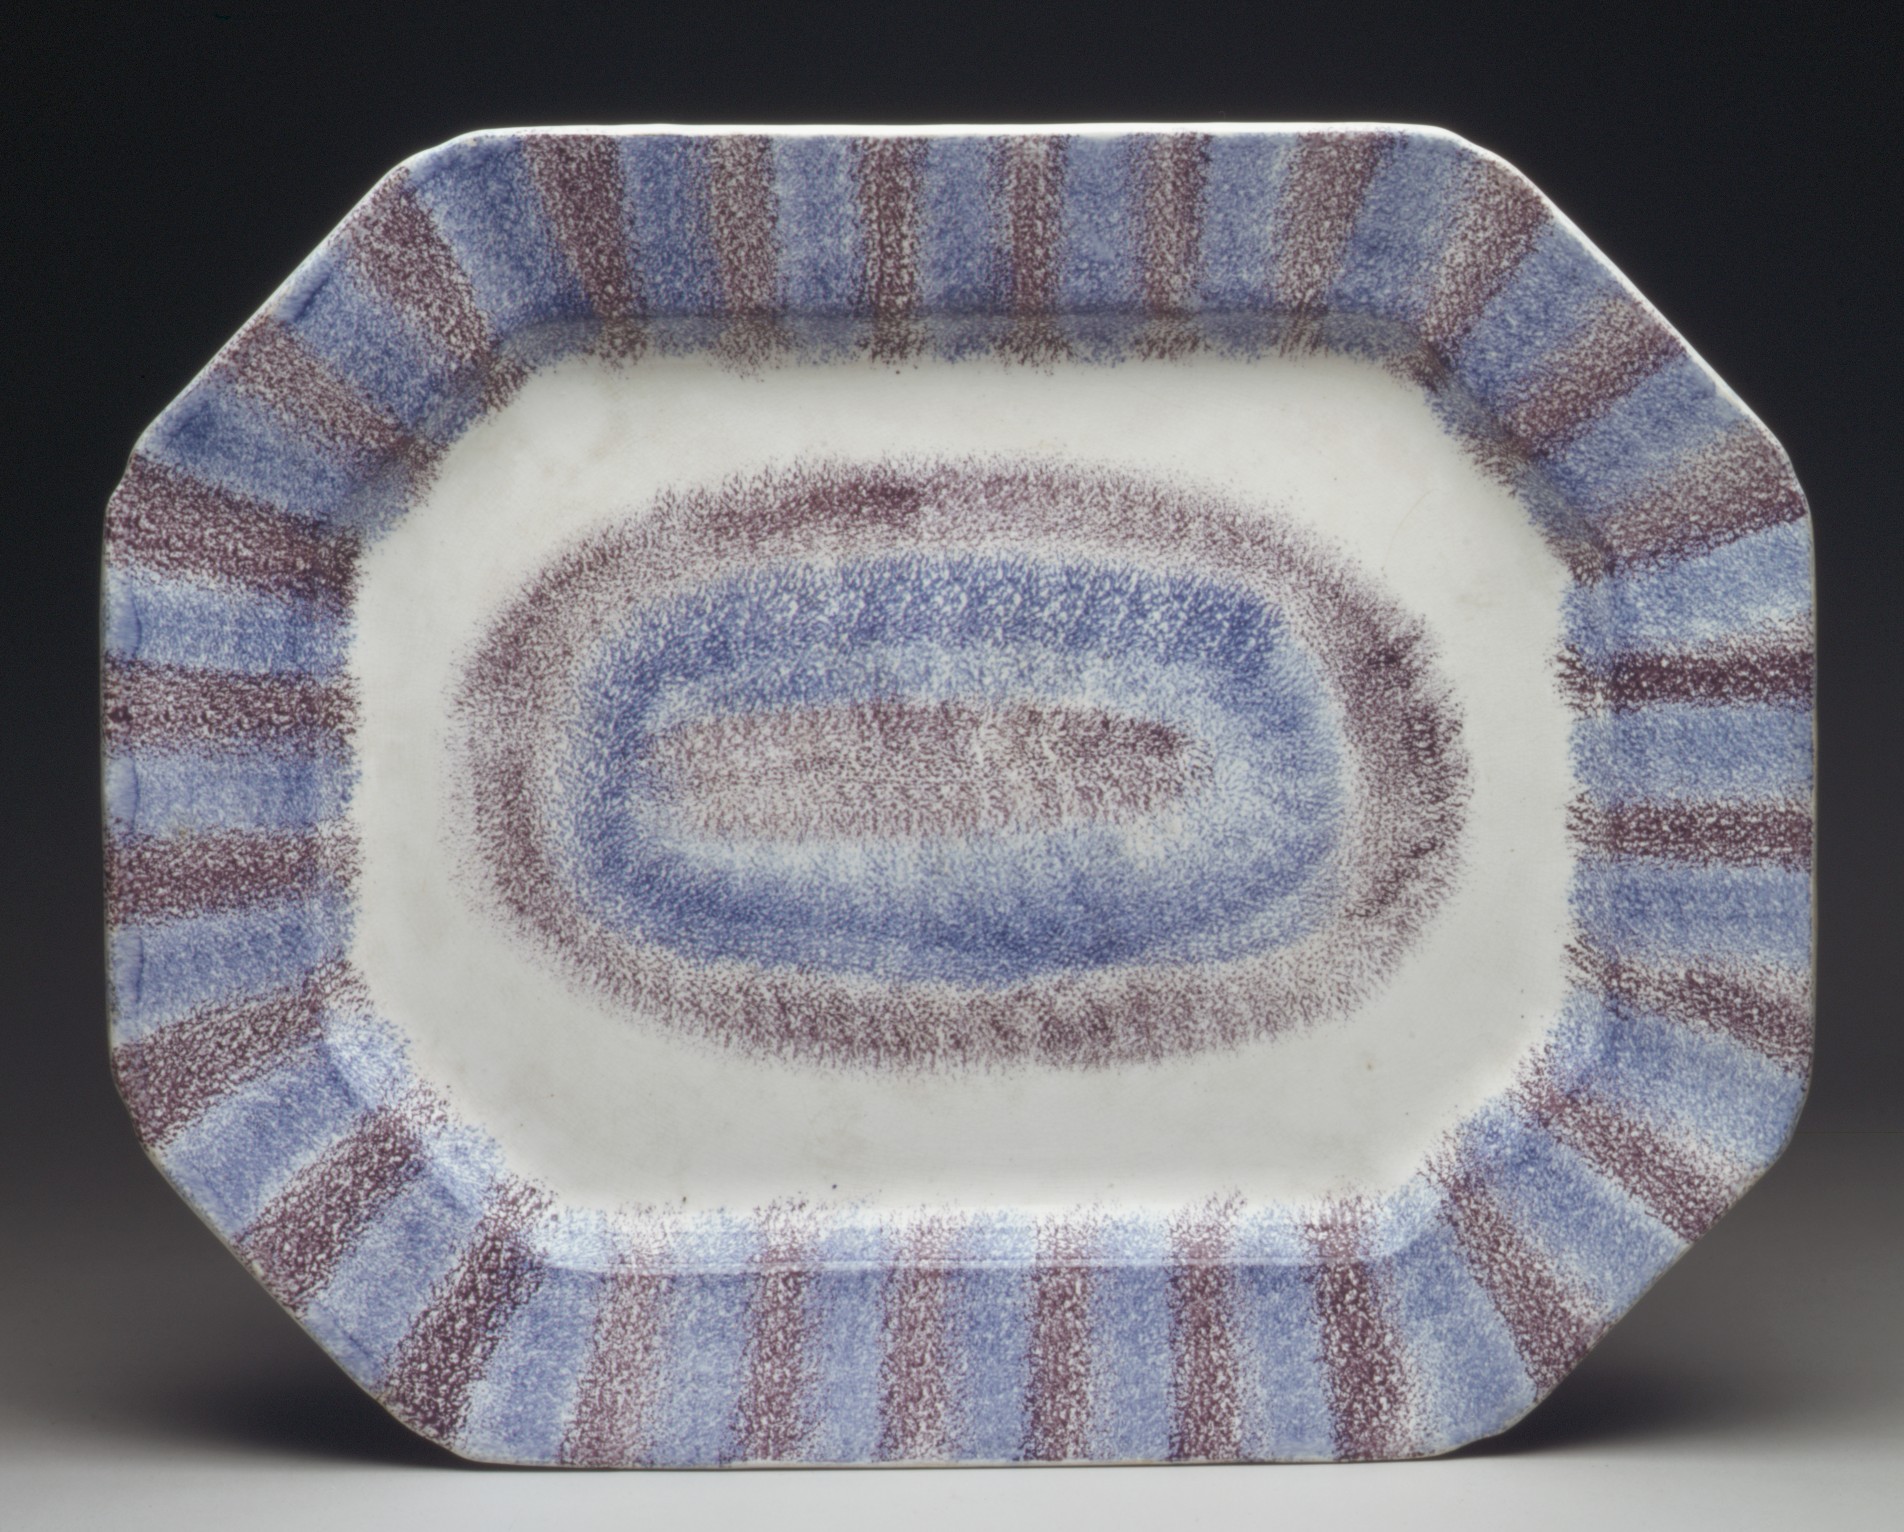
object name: platter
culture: british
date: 1800-1830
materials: earthenware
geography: england